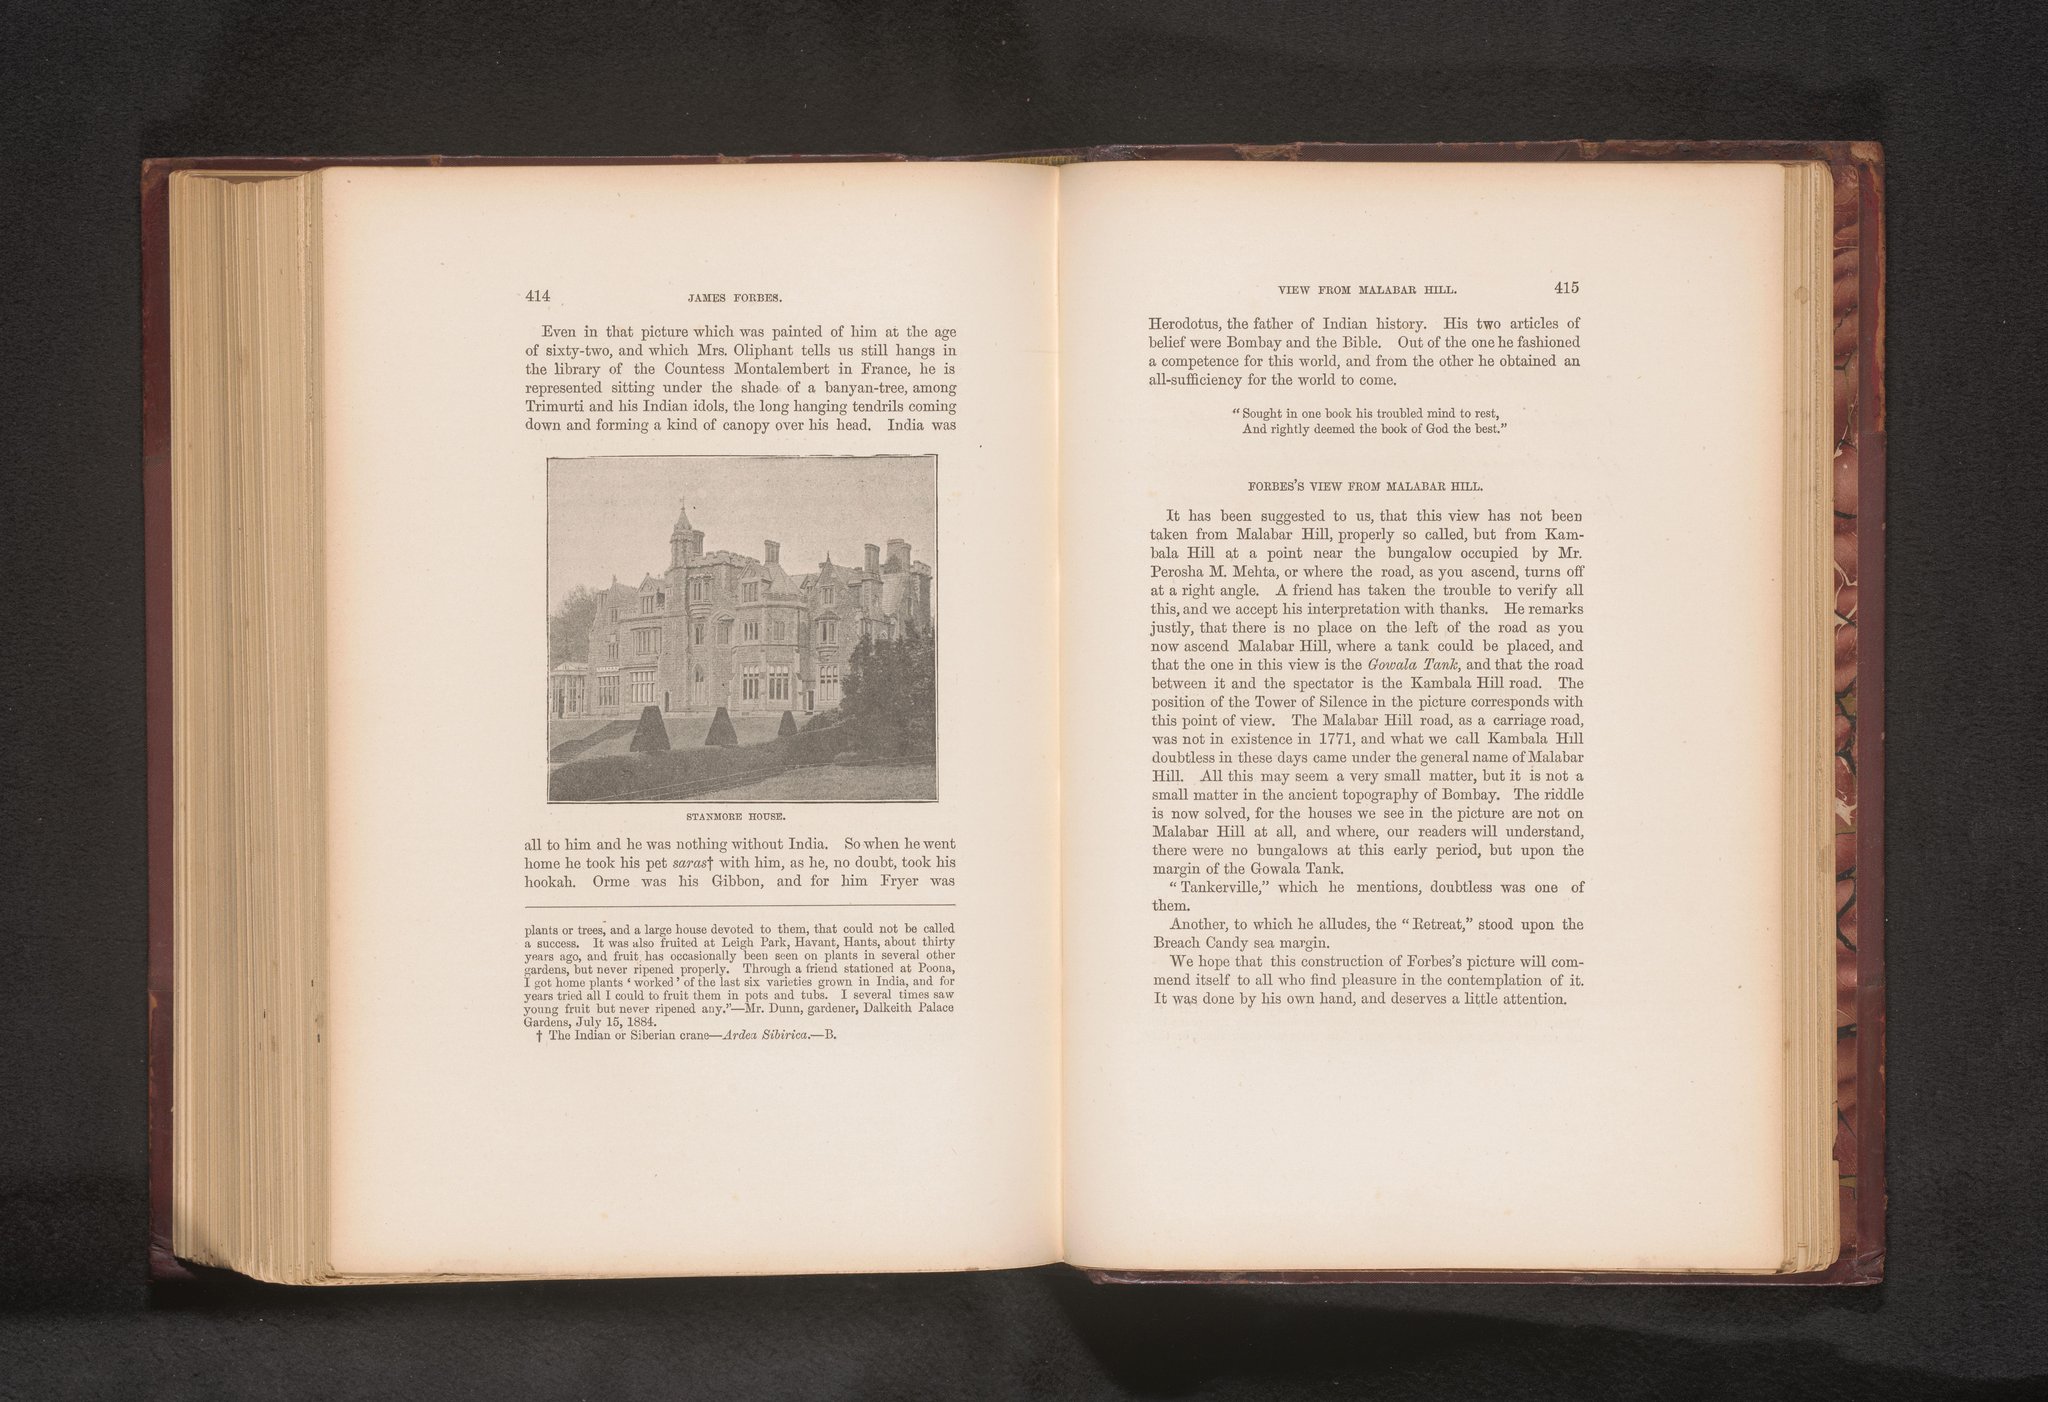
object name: page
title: Stanmore house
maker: Anonymous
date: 1883-1893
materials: paper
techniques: autotype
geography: london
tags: façade (of house or building), country-house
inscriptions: caption: ‘STANMORE HOUSE.’